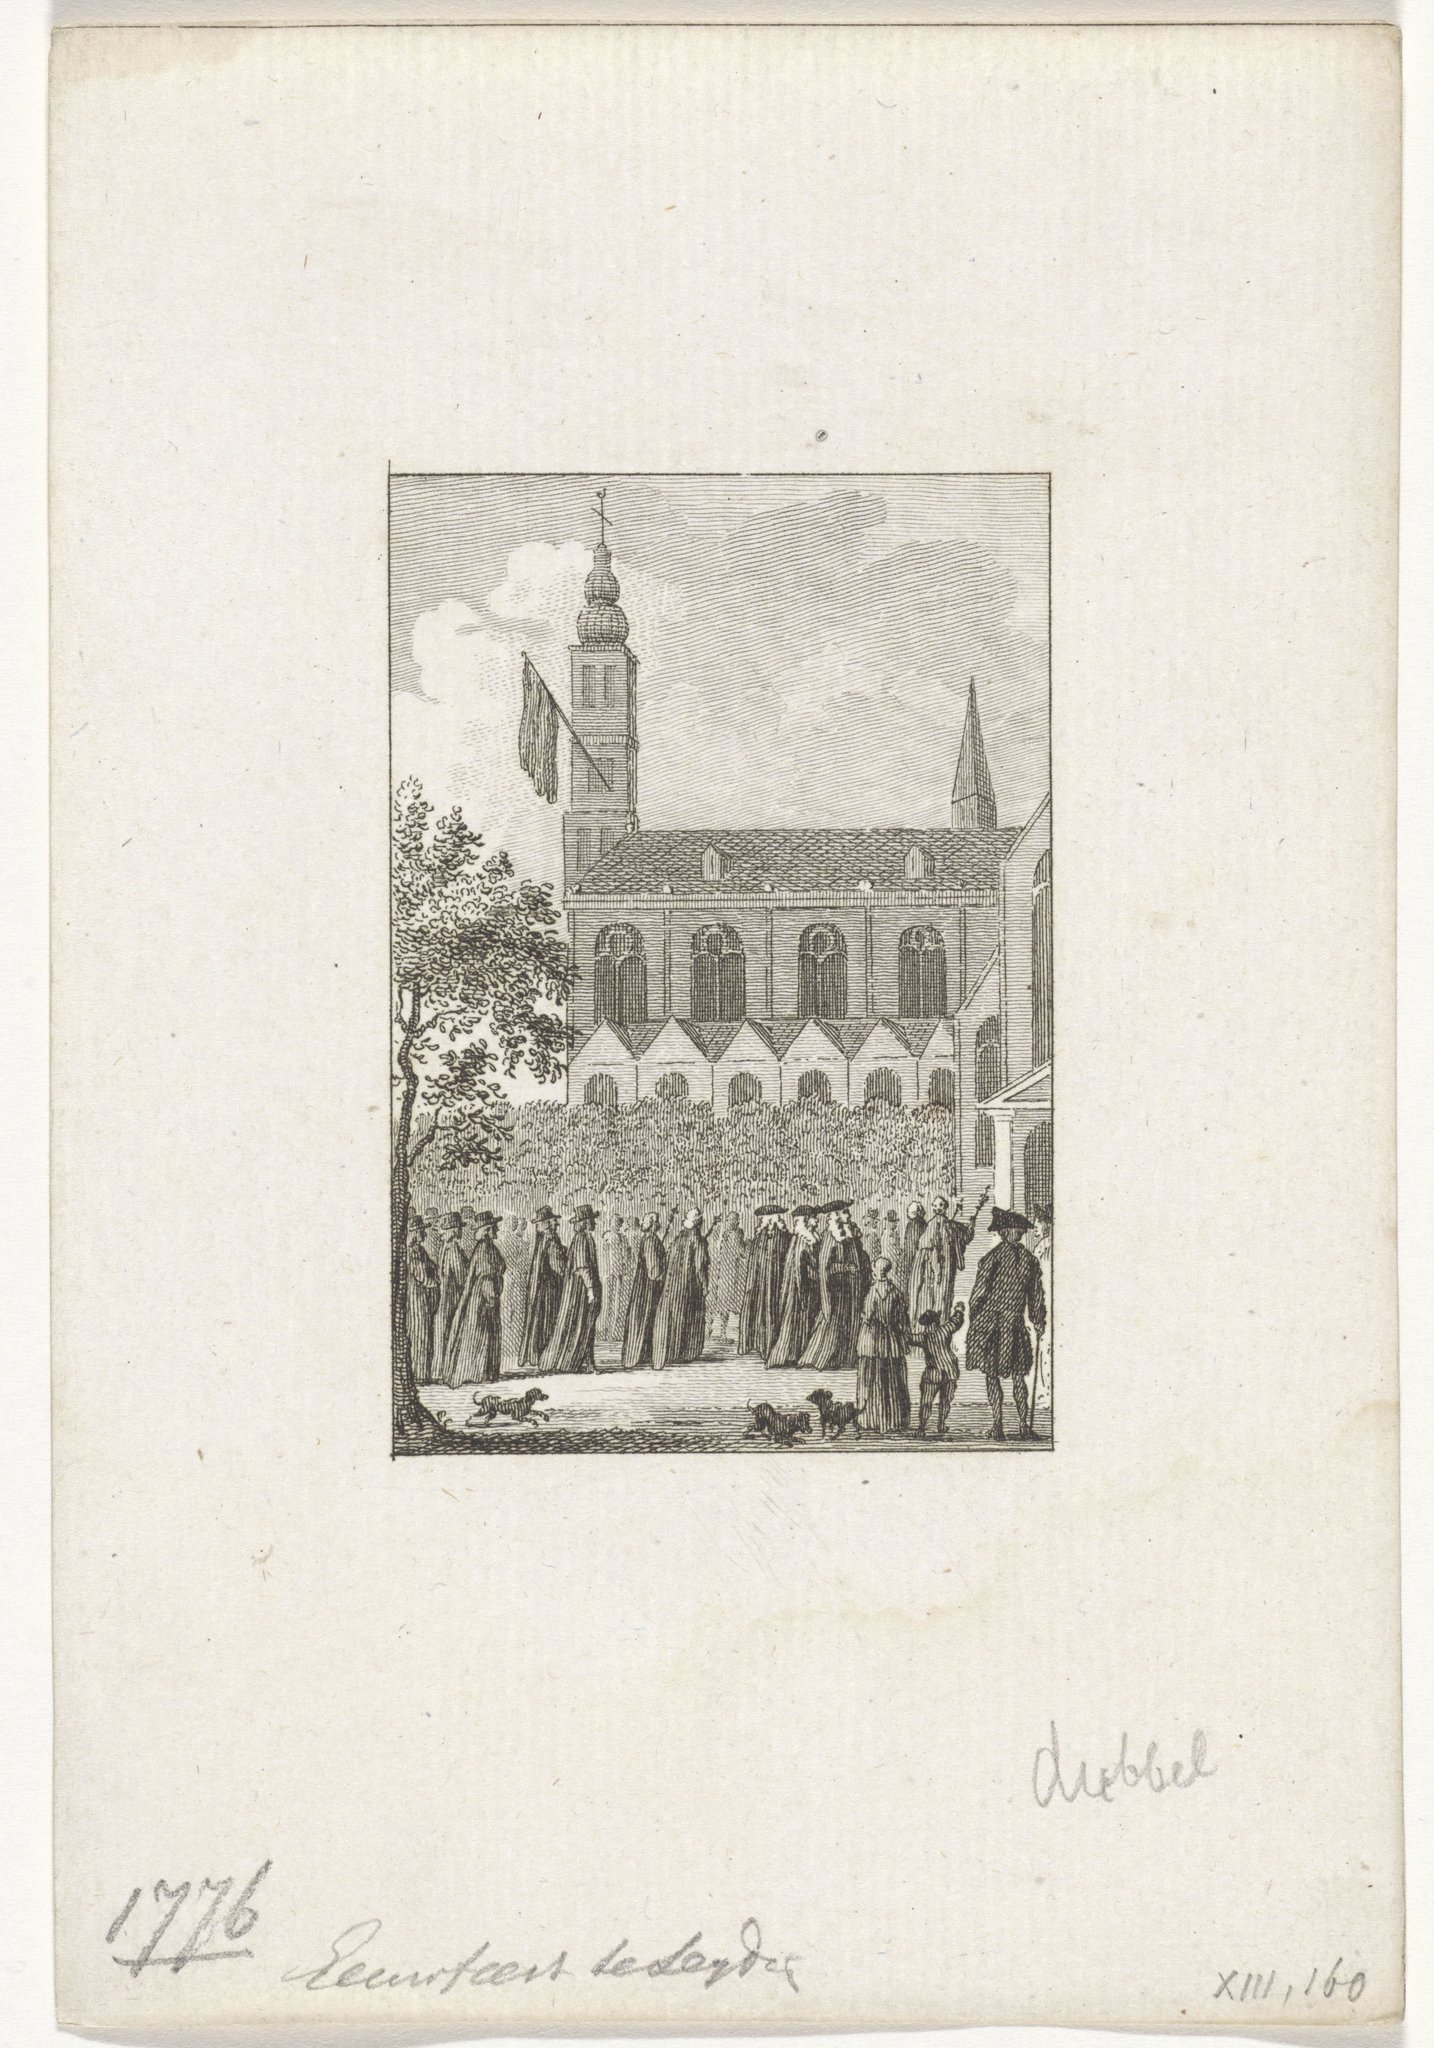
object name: print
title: Eeuwfeest te Leiden, 1776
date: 1776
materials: paper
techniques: engraving, etching